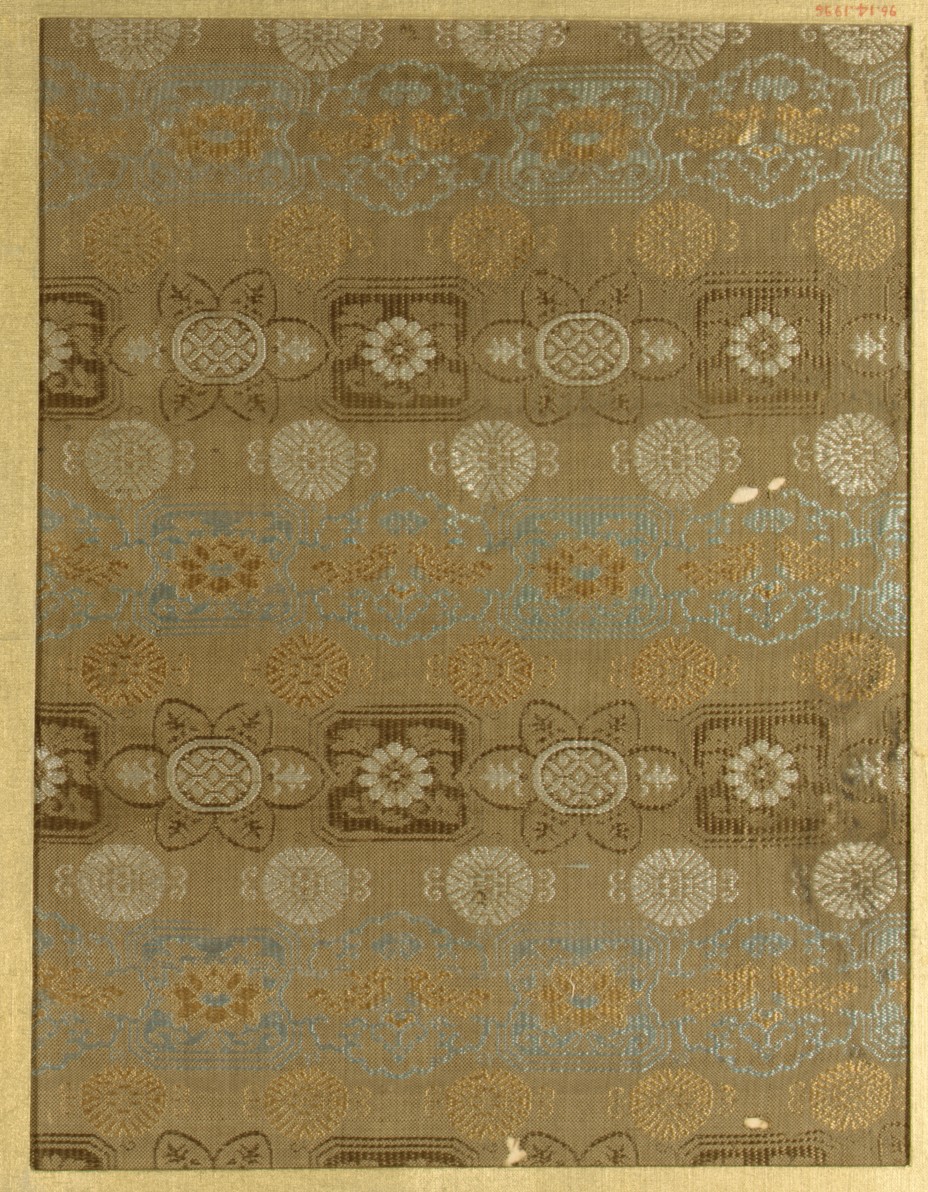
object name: piece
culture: japanese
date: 1701-1900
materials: silk